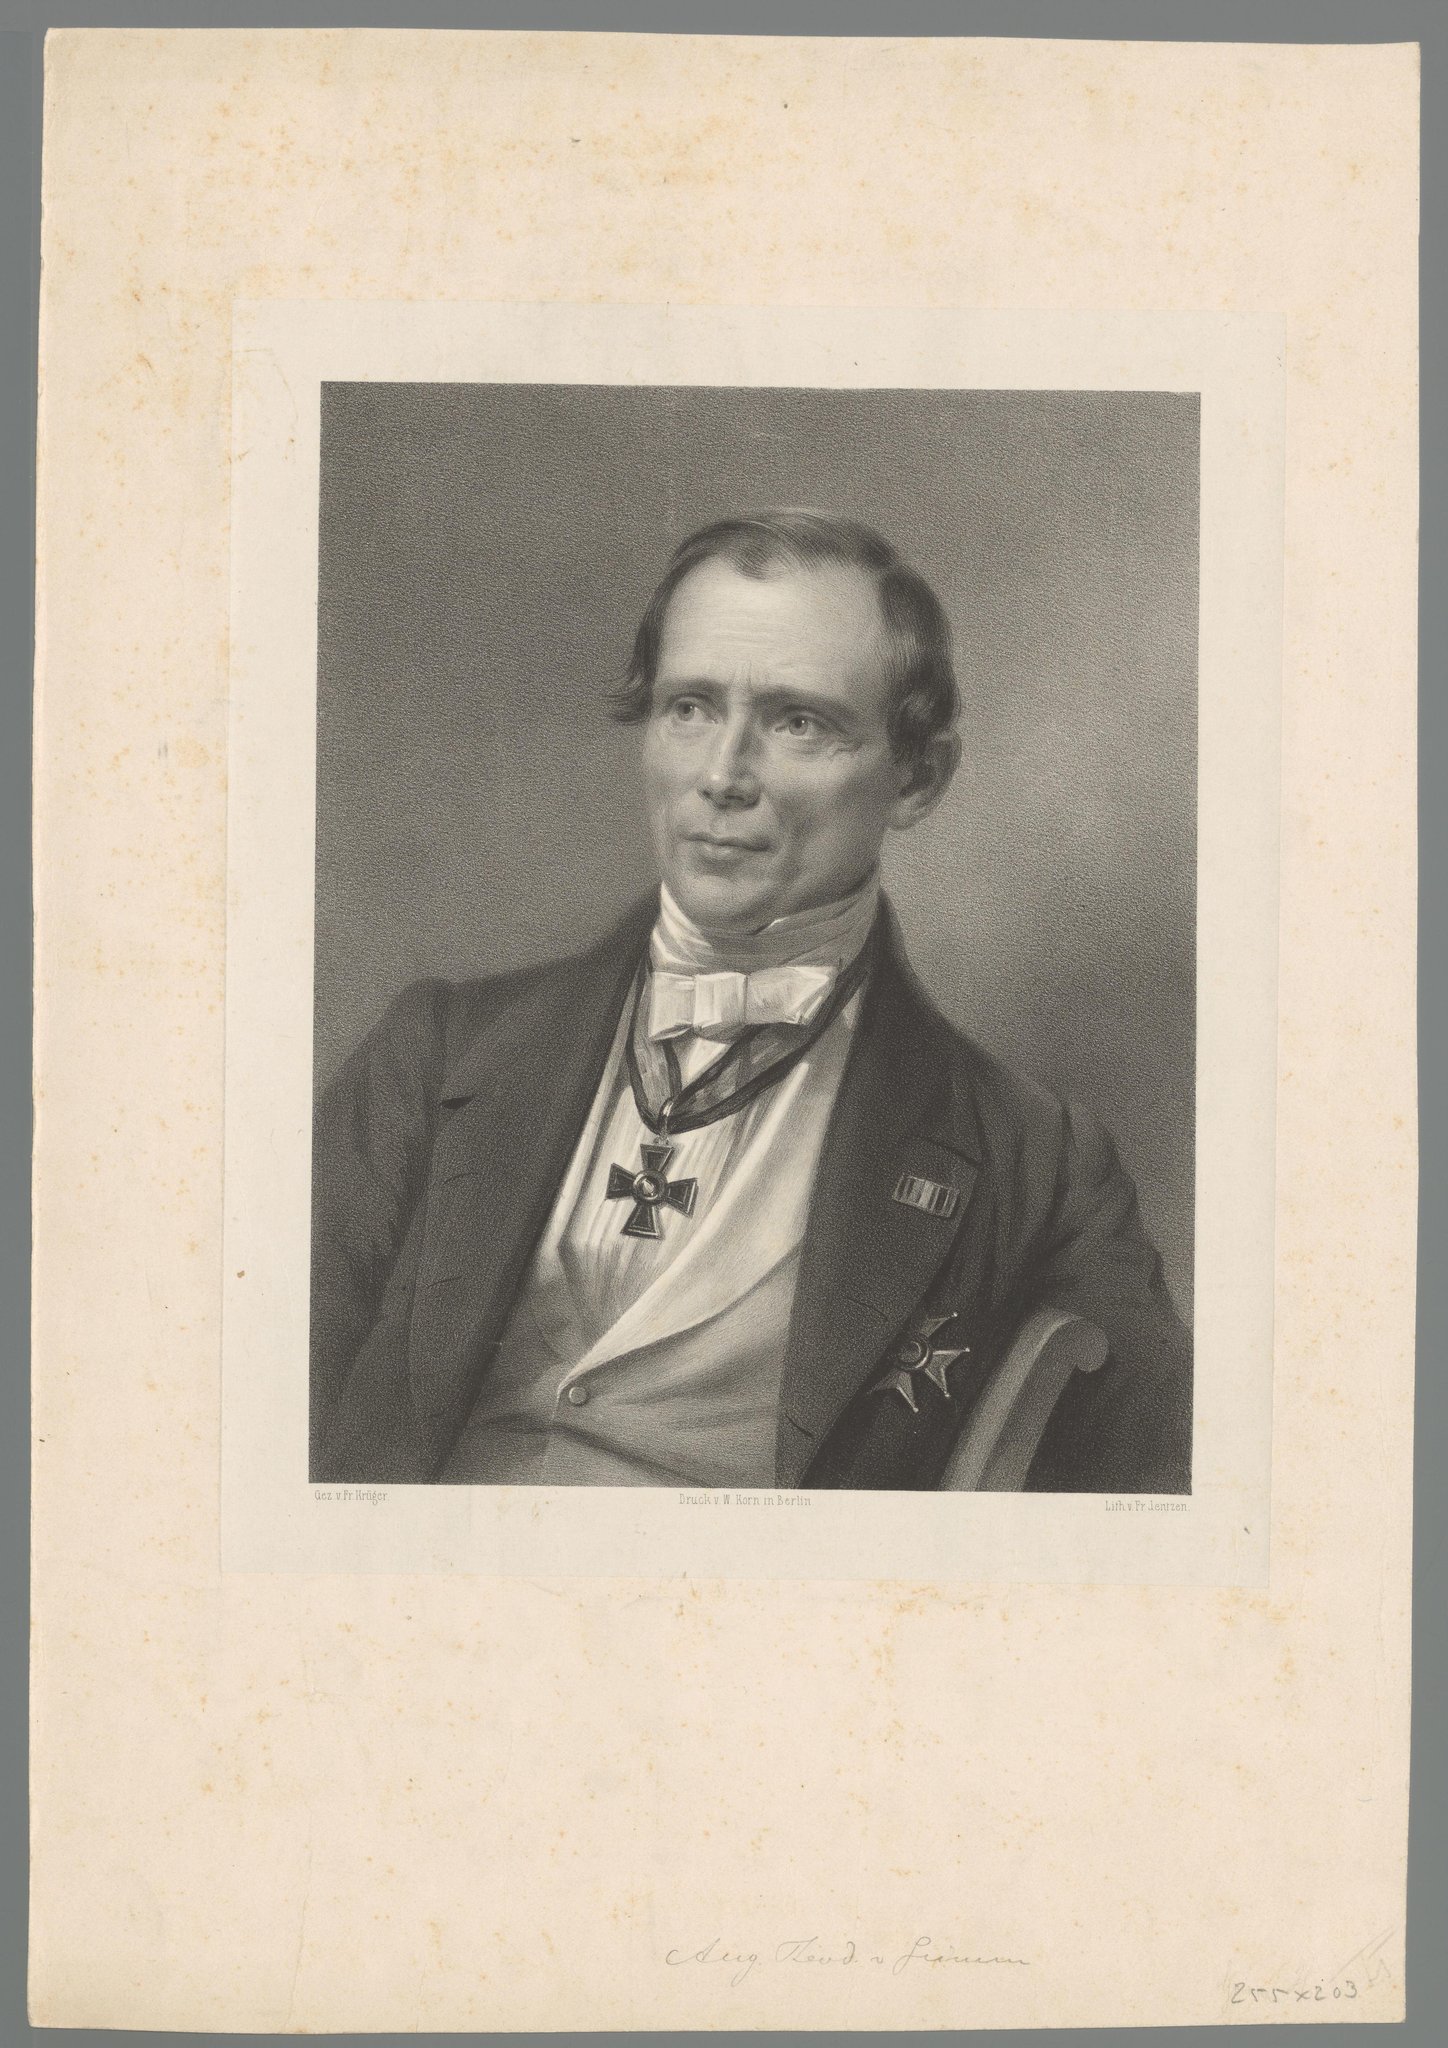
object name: print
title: Portret van August Theodor Grimm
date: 1830-1875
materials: paper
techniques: lithograph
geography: berlin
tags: adult man, historical persons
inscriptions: collector's mark: Lugt 2228